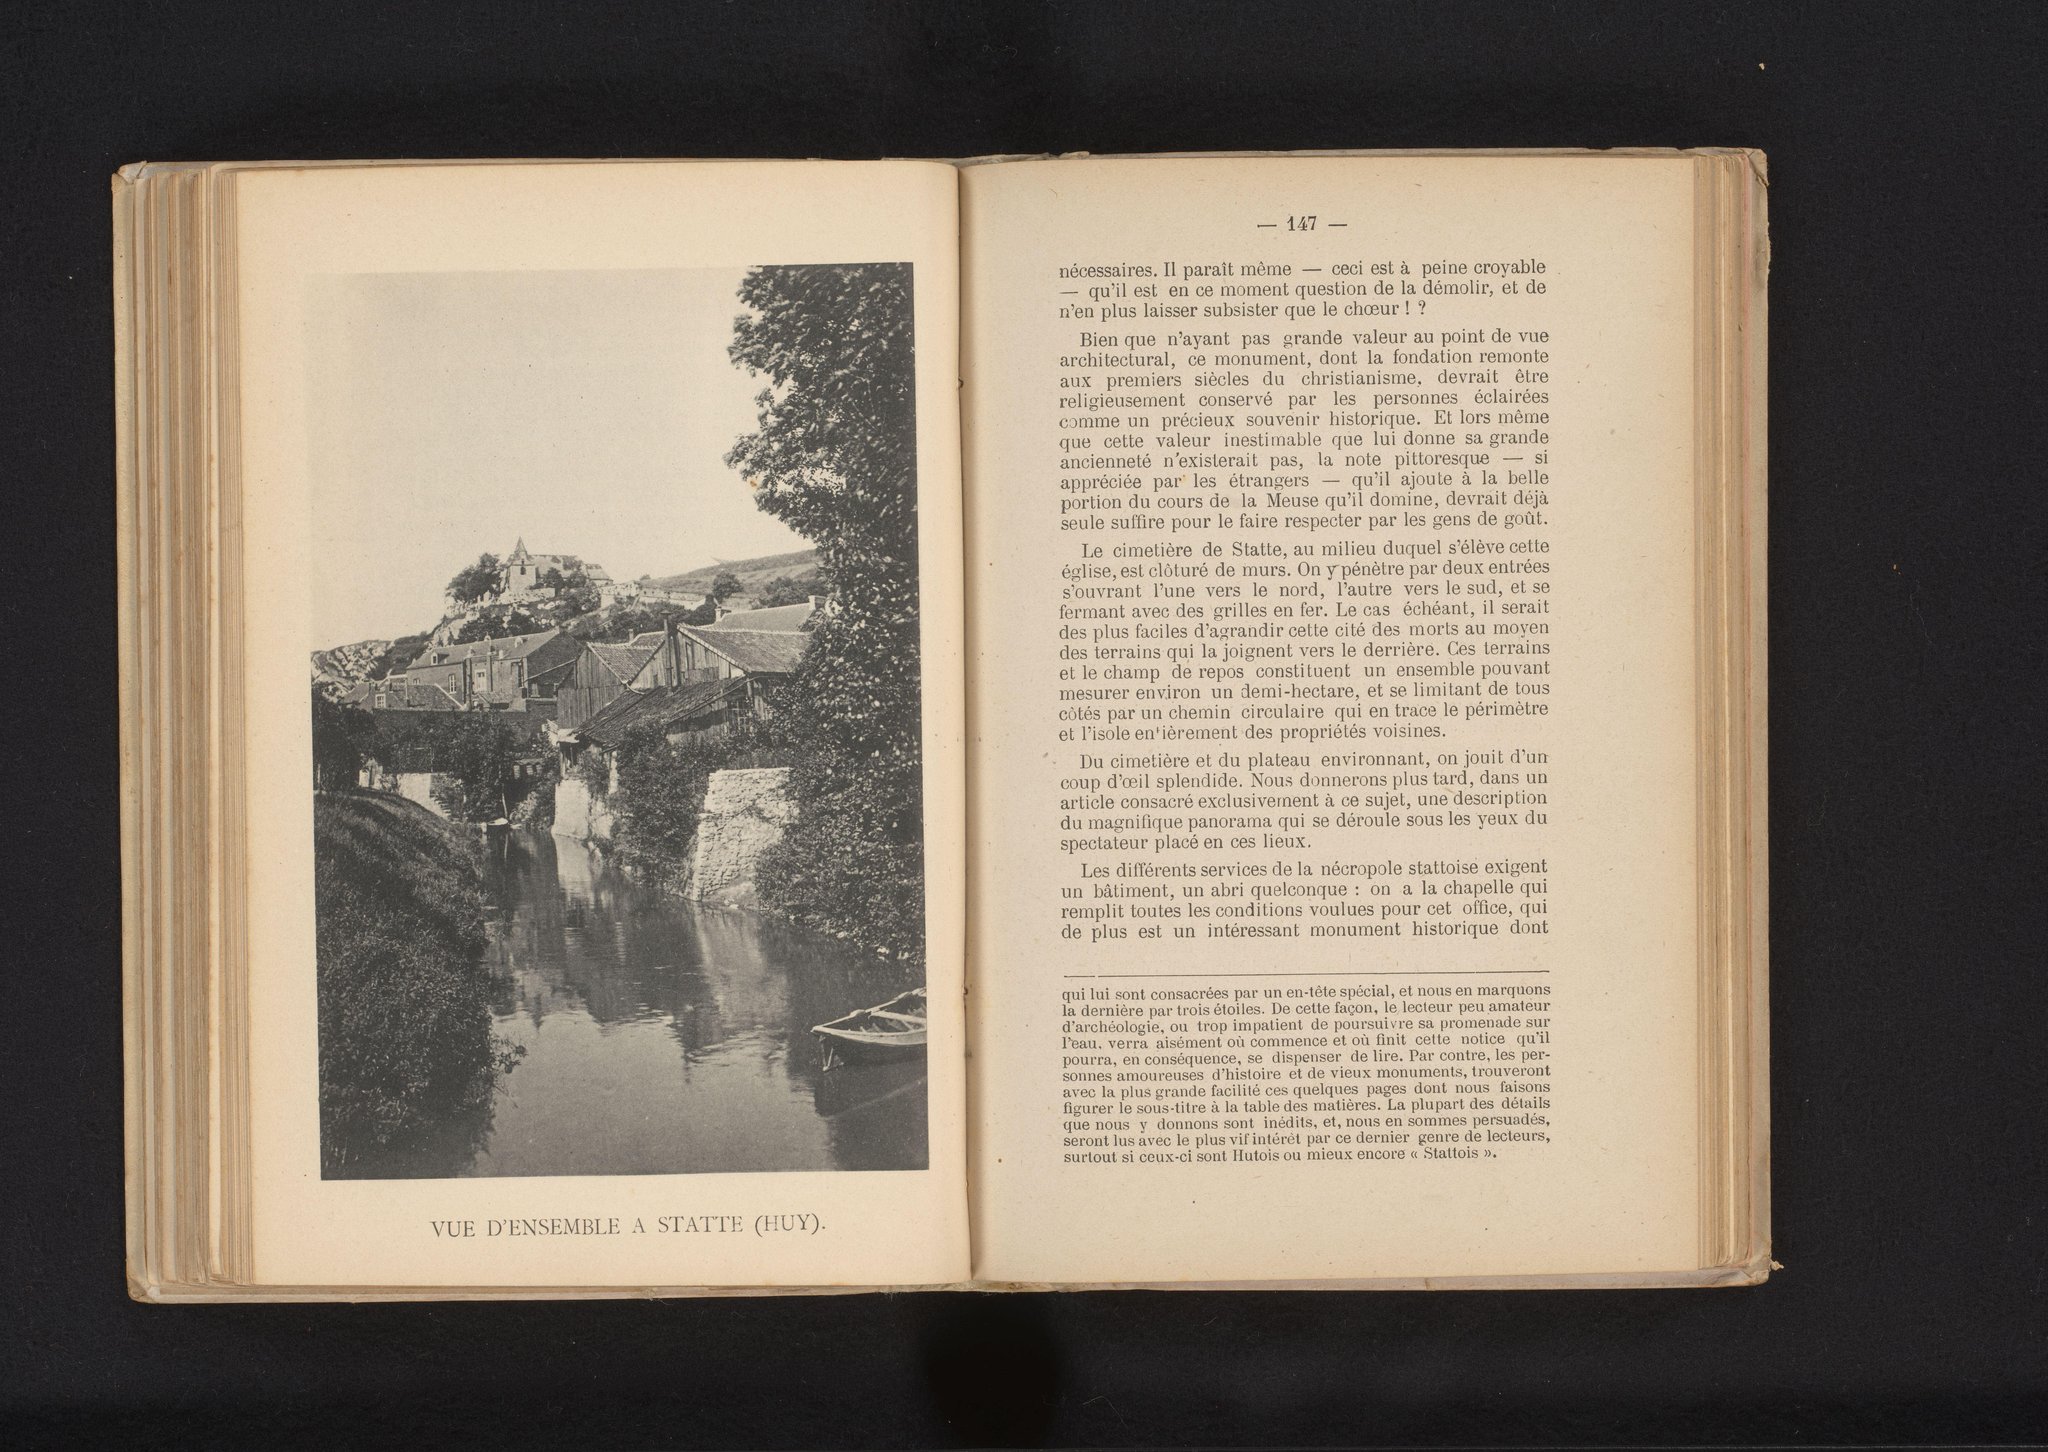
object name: photomechanical print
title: Vue d'Ensemble a Statte (Huy)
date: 1885-1890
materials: paper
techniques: photograph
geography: brussels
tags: prospect of city, town panorama, silhouette of city